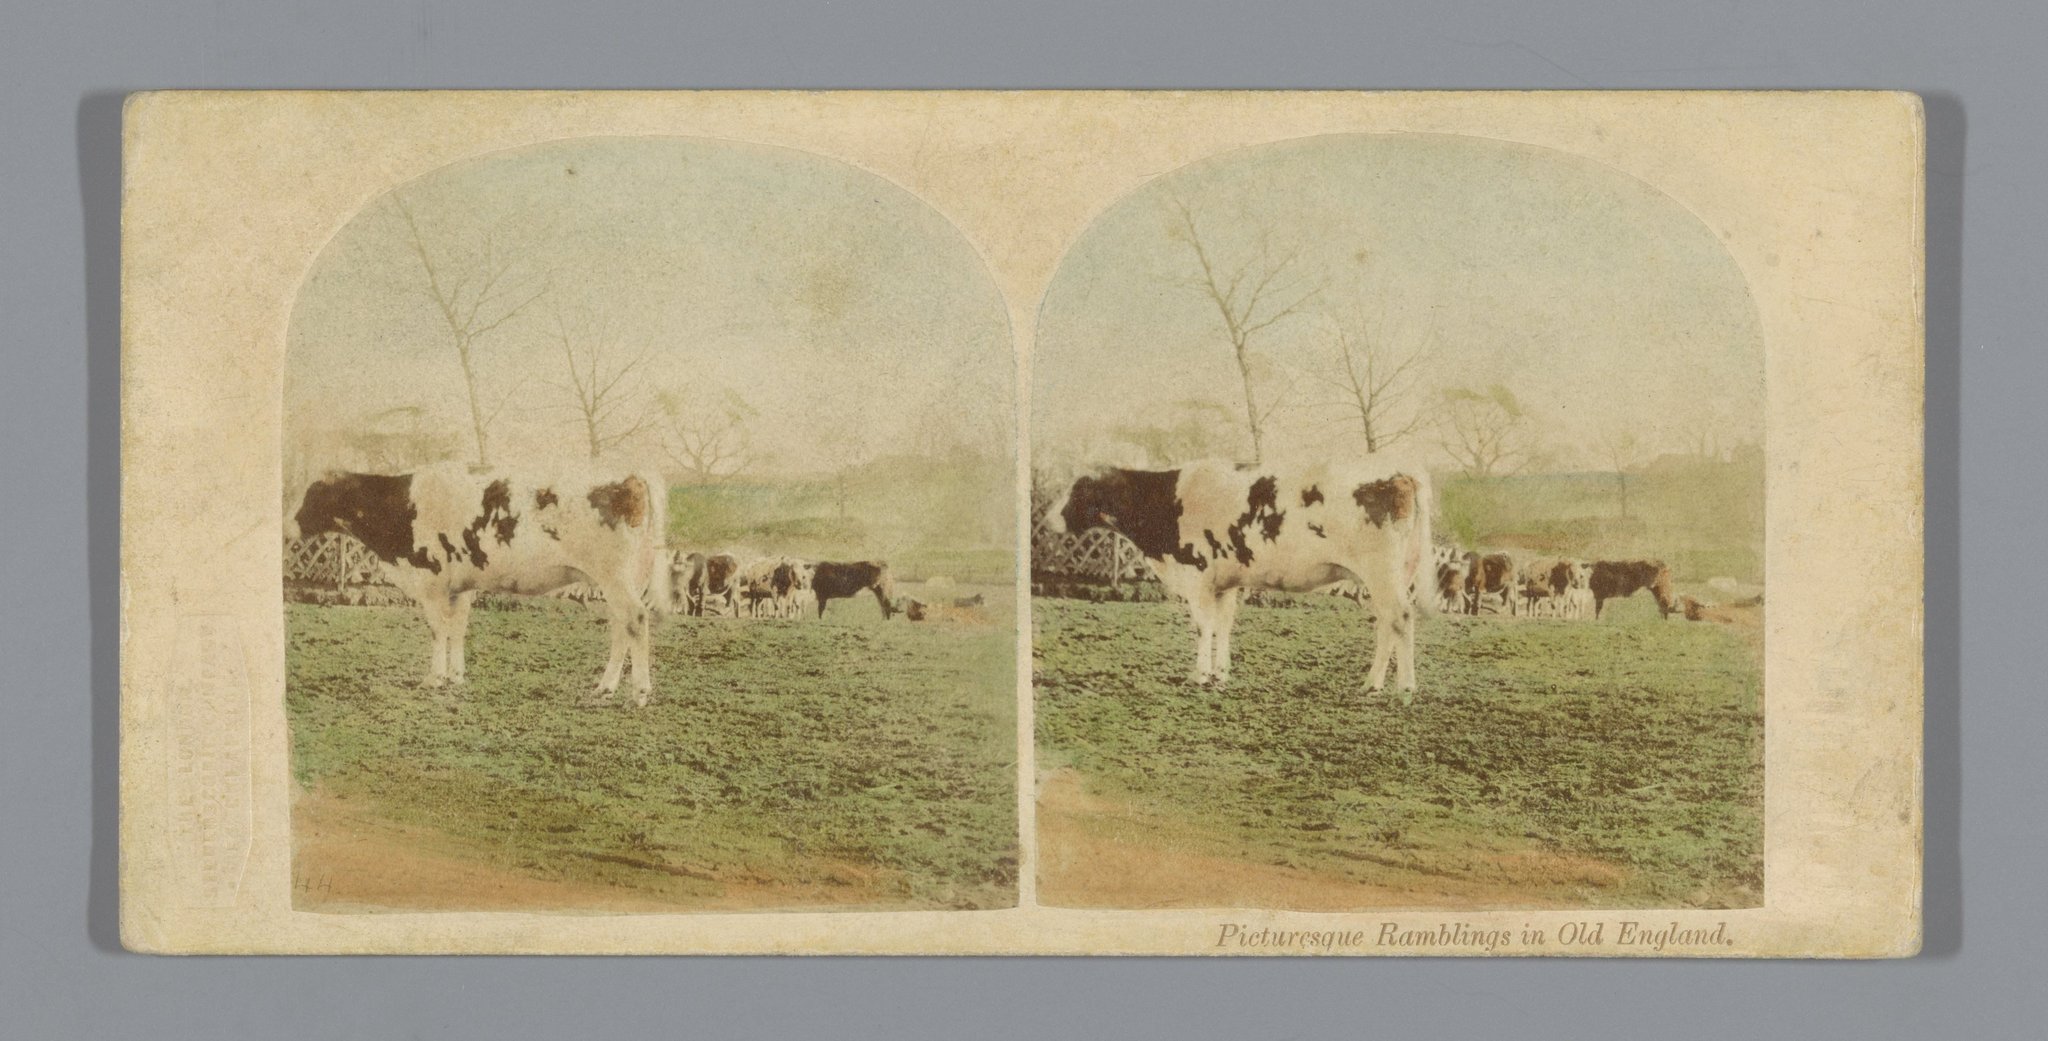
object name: stereograph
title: Picturesque Ramblings in Old England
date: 1854-1880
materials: cardboard, photographic support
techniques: albumen print, hand coloring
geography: england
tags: cow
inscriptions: name: ‘The London Stereoscopic Company 54. Cheapside’, number: ‘44’